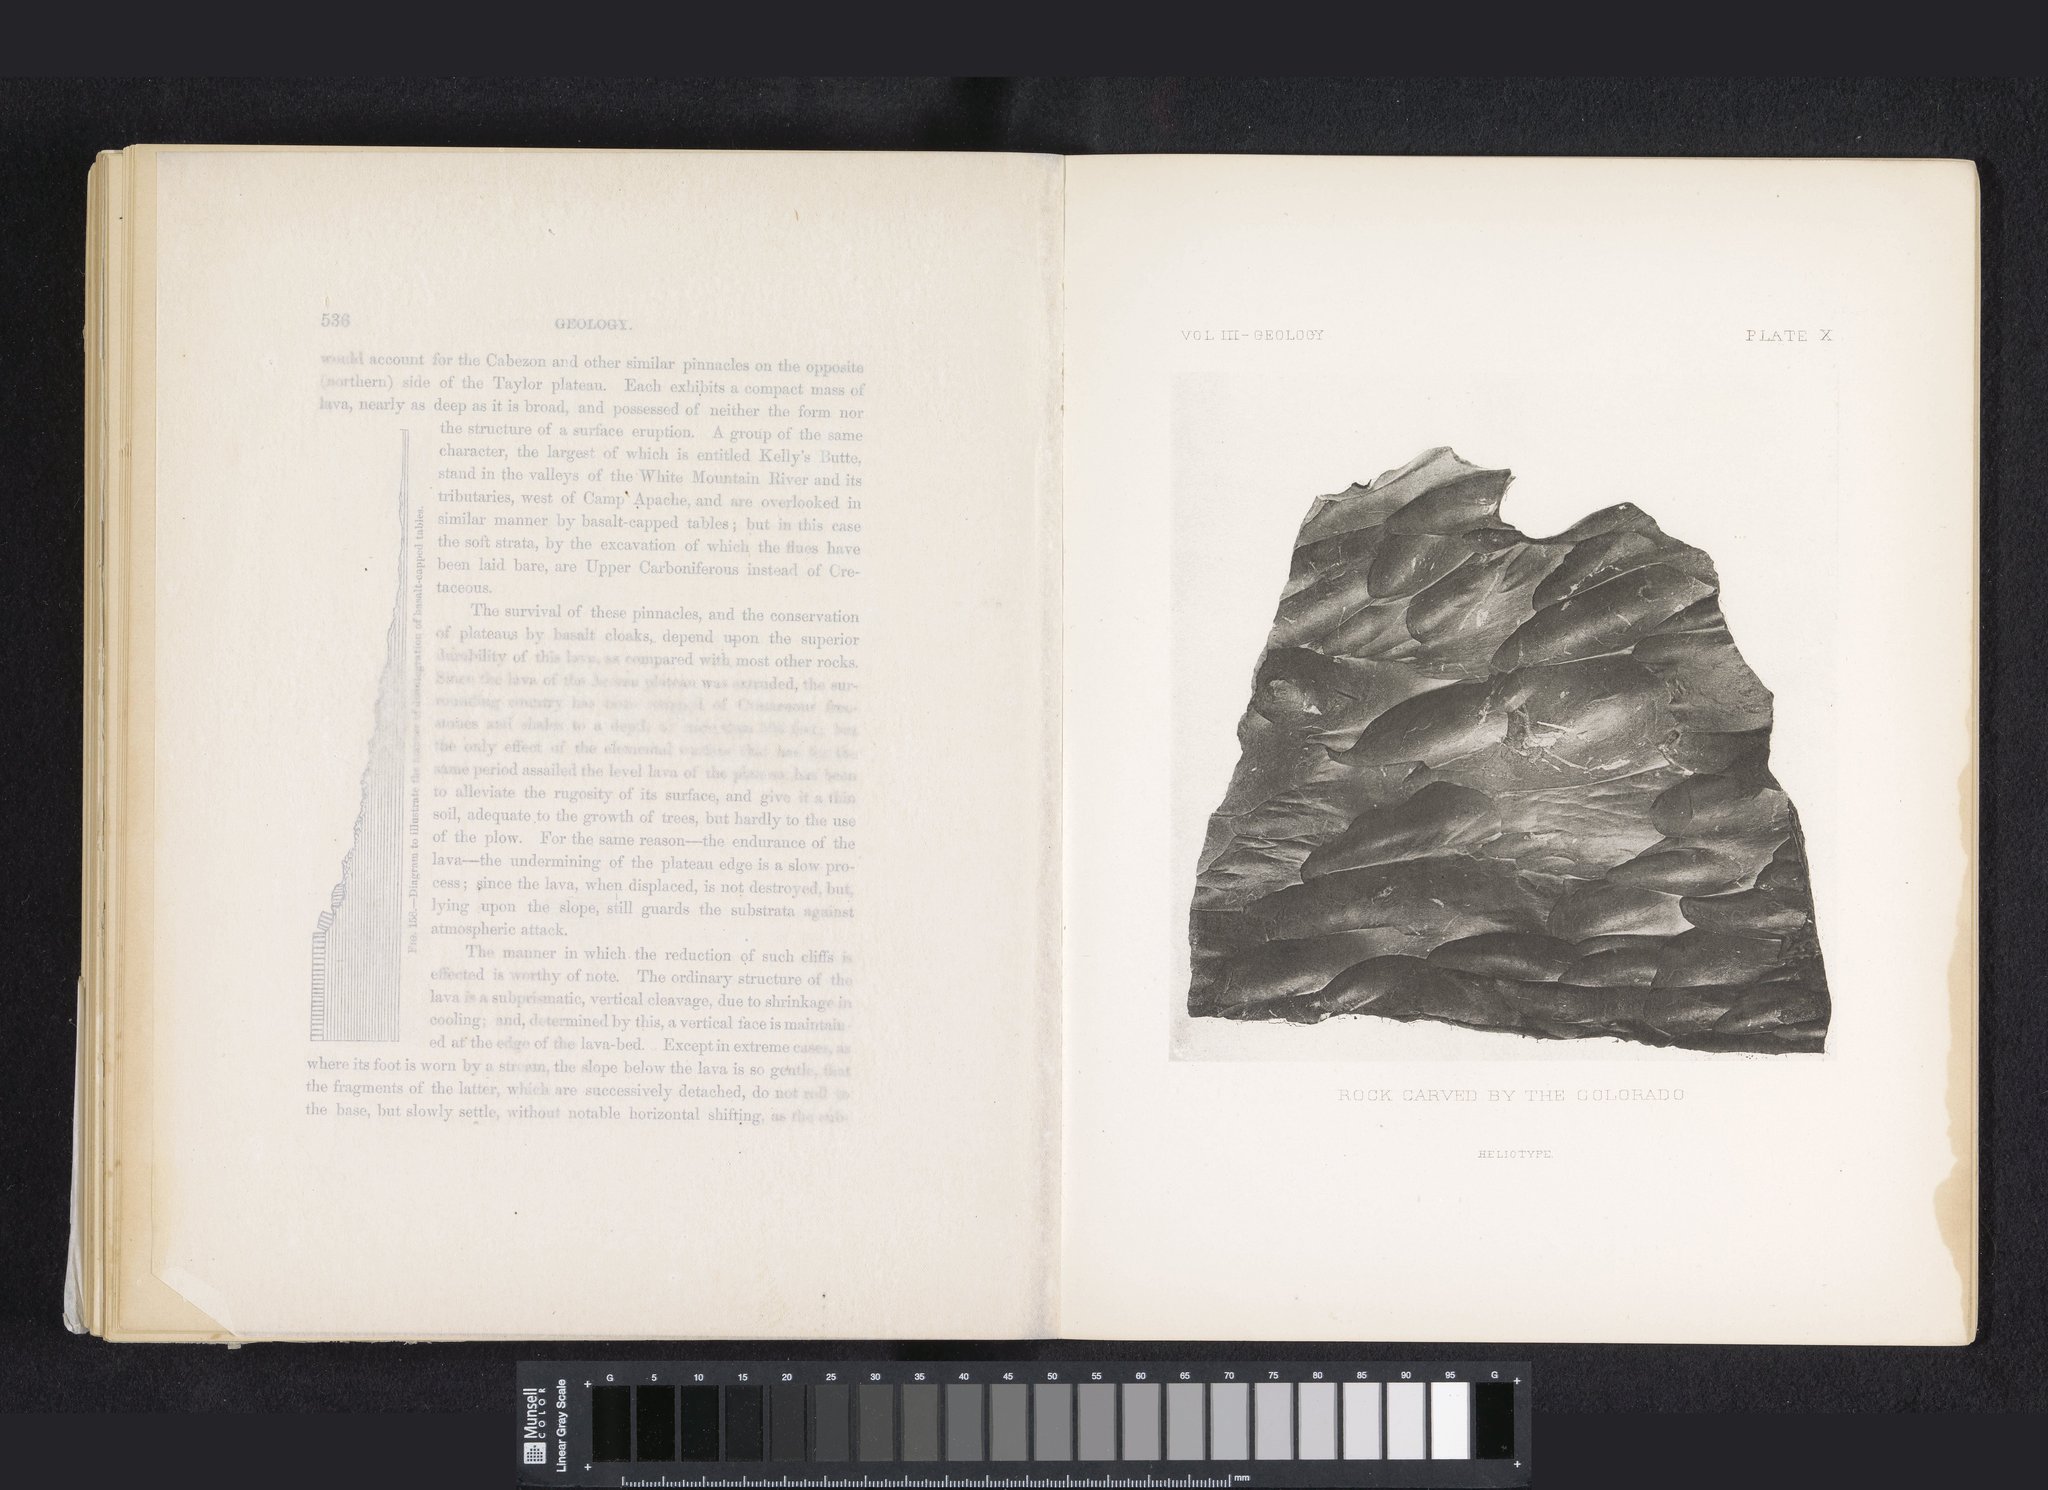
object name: page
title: Rock carved by the Colorado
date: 1871-1875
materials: paper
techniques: photograph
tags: rock types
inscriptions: number: ‘Plate X’